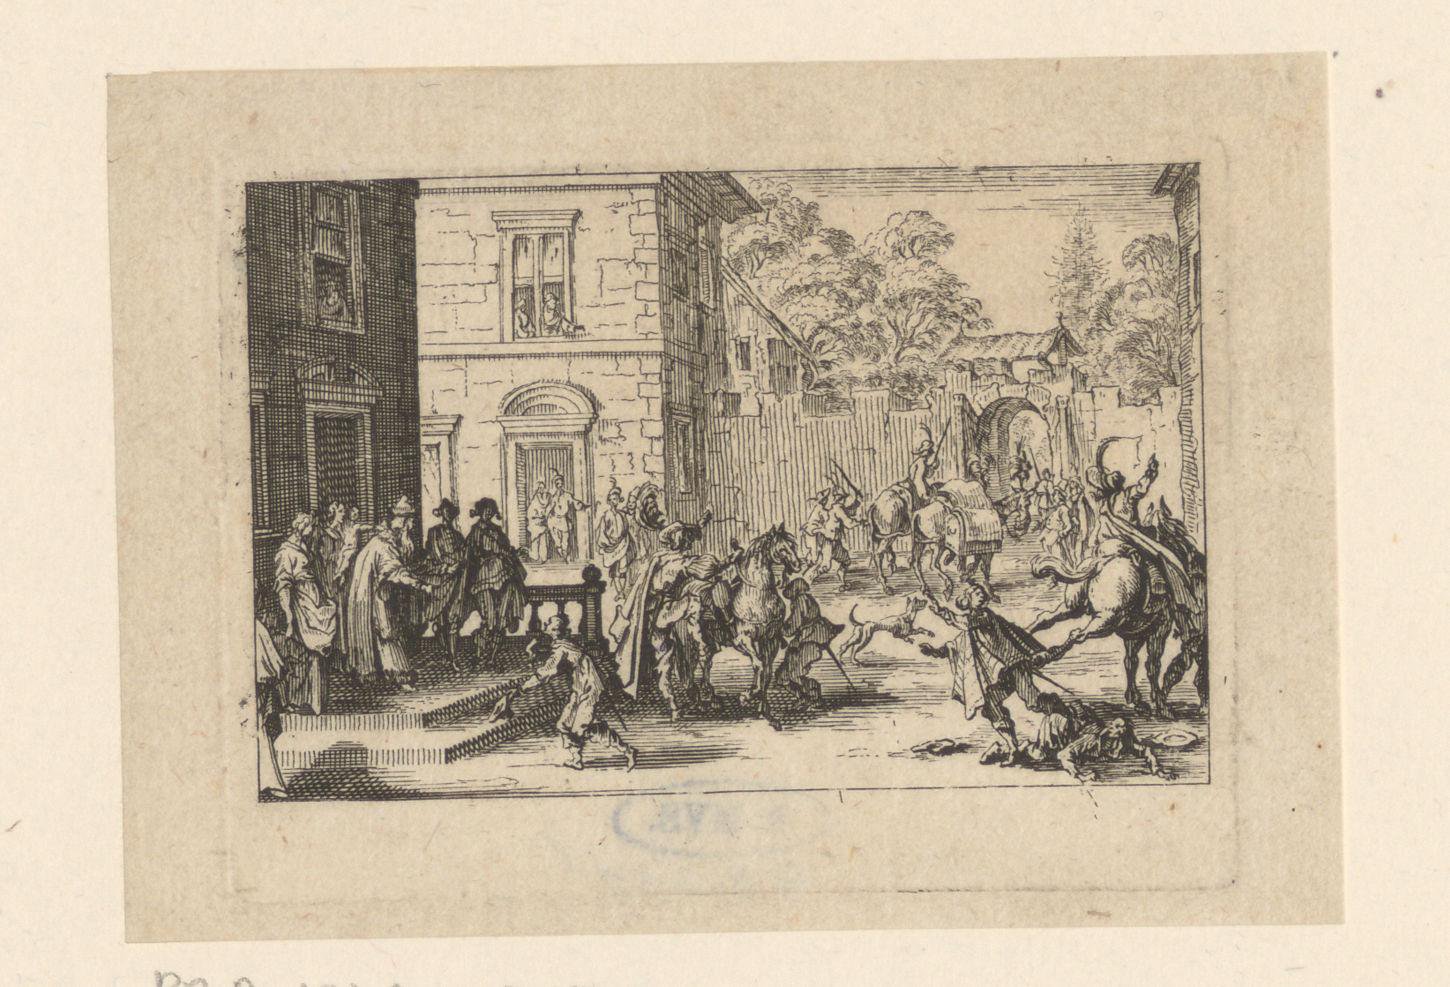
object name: print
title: La Vie de l'Efant prodigue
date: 1677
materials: paper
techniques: etching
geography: augsburg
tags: leave-taking and departure of the prodigal son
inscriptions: collector's mark: Lugt 2228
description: Deze prent maakt deel uit van een serie van in ieder geval tien prenten.